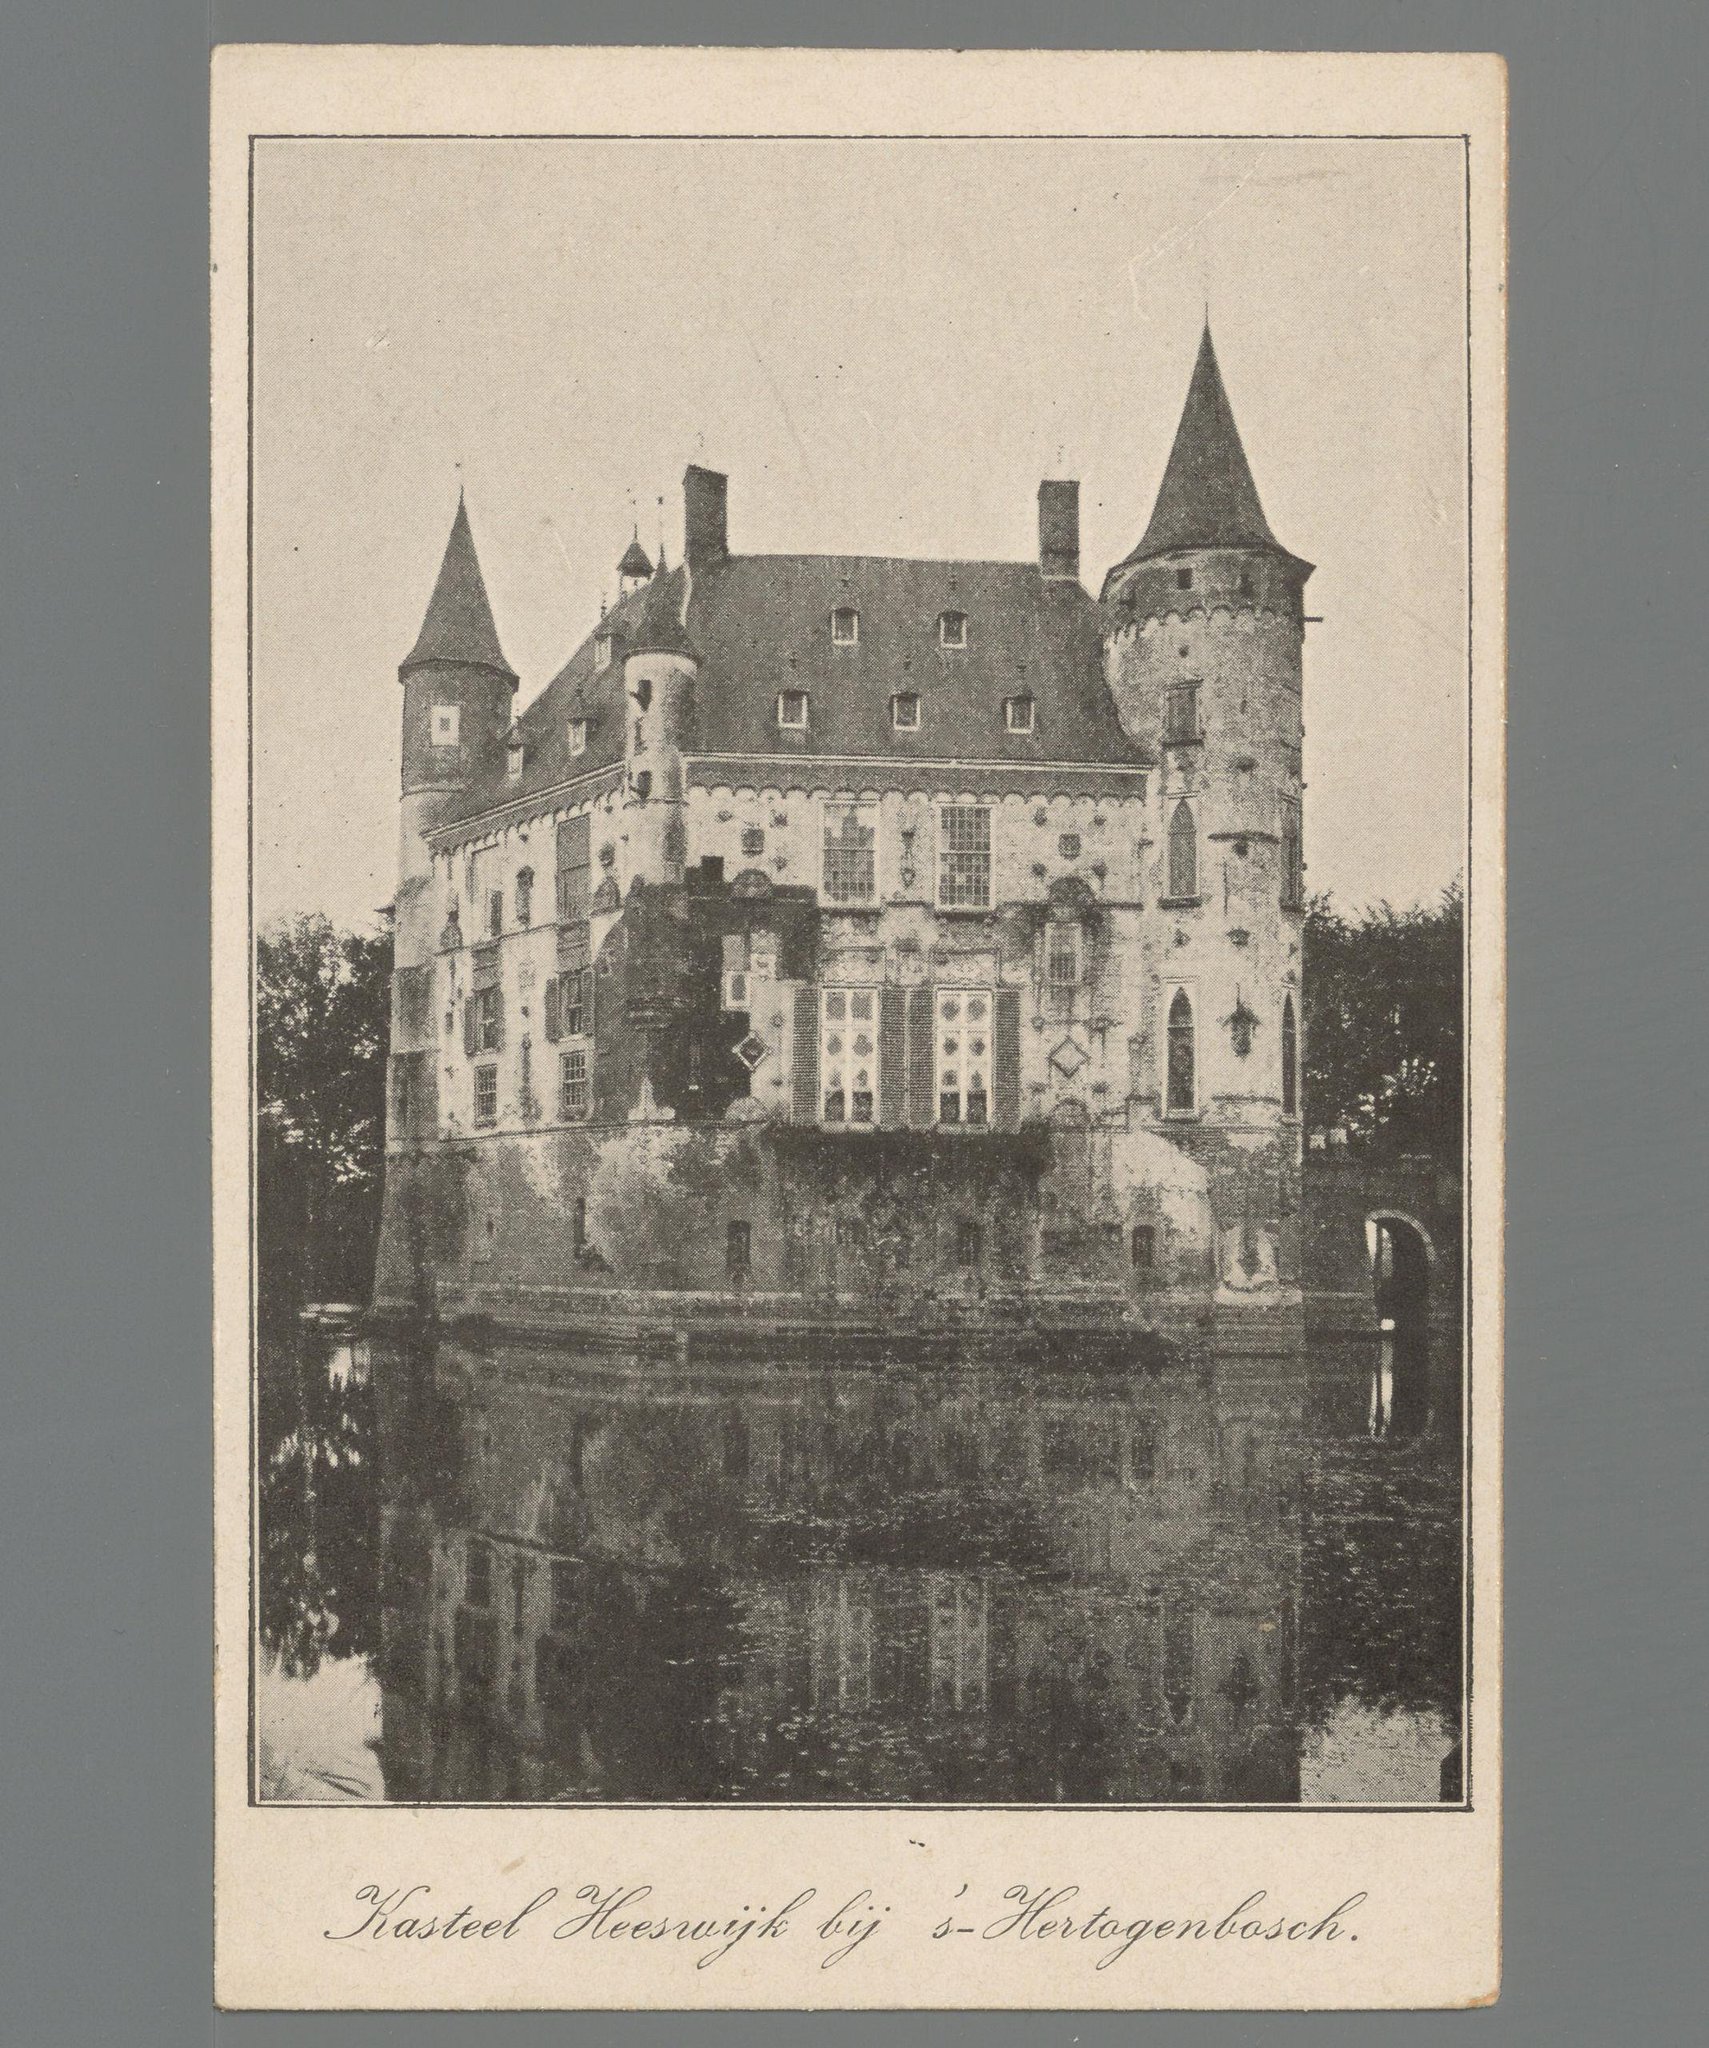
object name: ansichtkaart, prentbriefkaart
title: Kasteel Heeswijk bij 's-Hertogenbosch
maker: Anonymous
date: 1898-1930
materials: cardboard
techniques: autotype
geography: heeswijk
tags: castle, canal